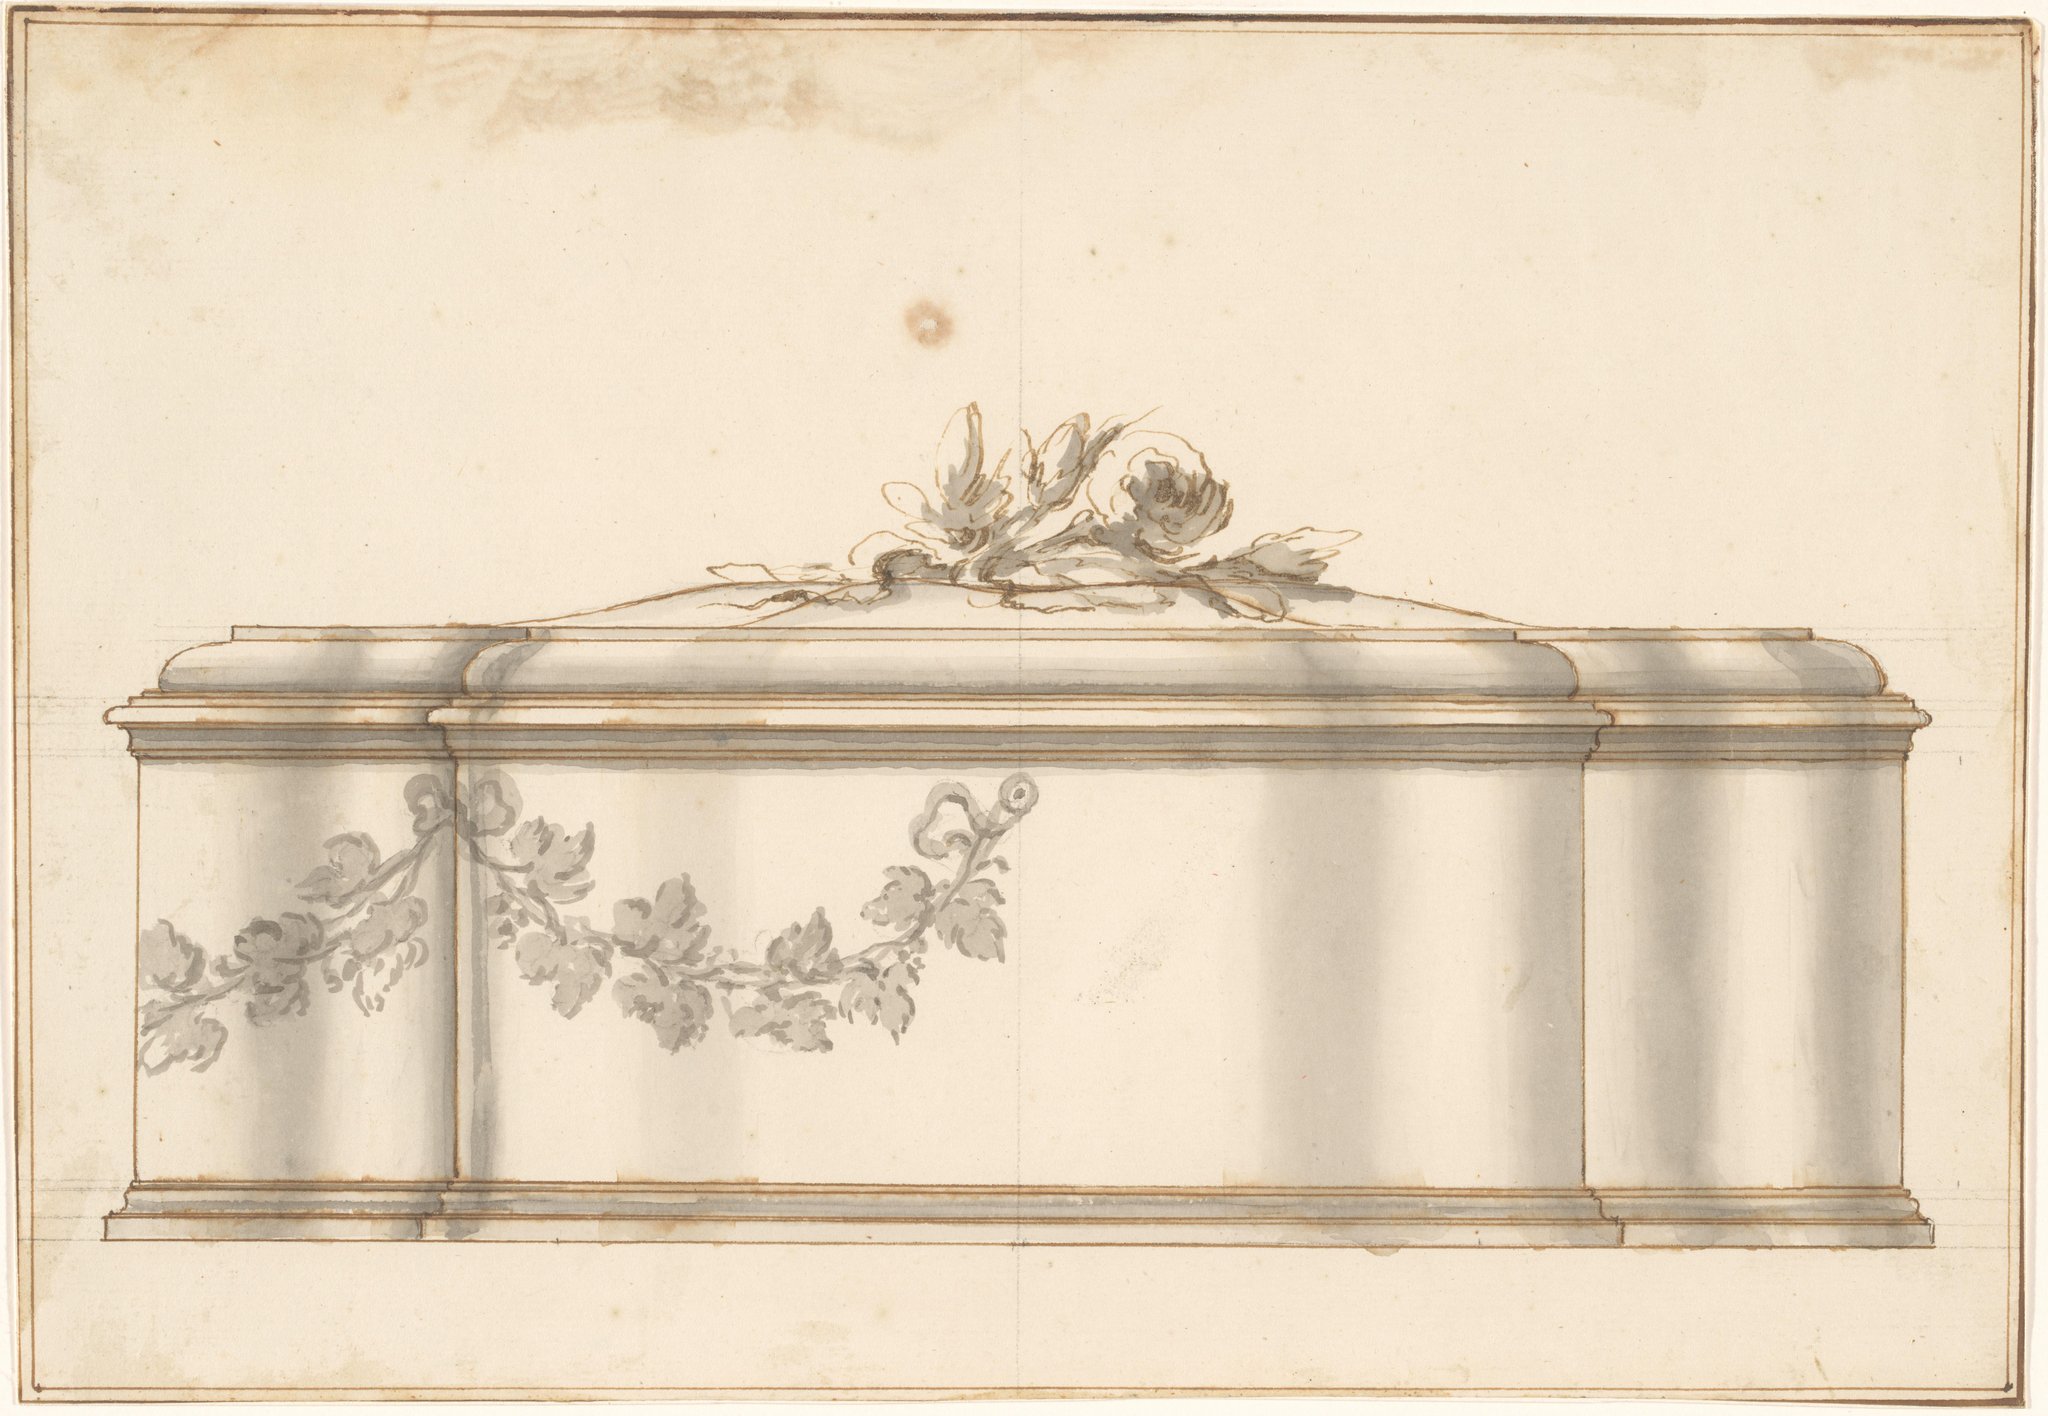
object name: drawing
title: Ontwerp voor een zilveren doos met deksel, met alternatieve oplossingen links en rechts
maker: luigi valadier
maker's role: draughtsman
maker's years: 1726-1785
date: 1760-1770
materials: graphite, ink, paper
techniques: brush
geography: rome